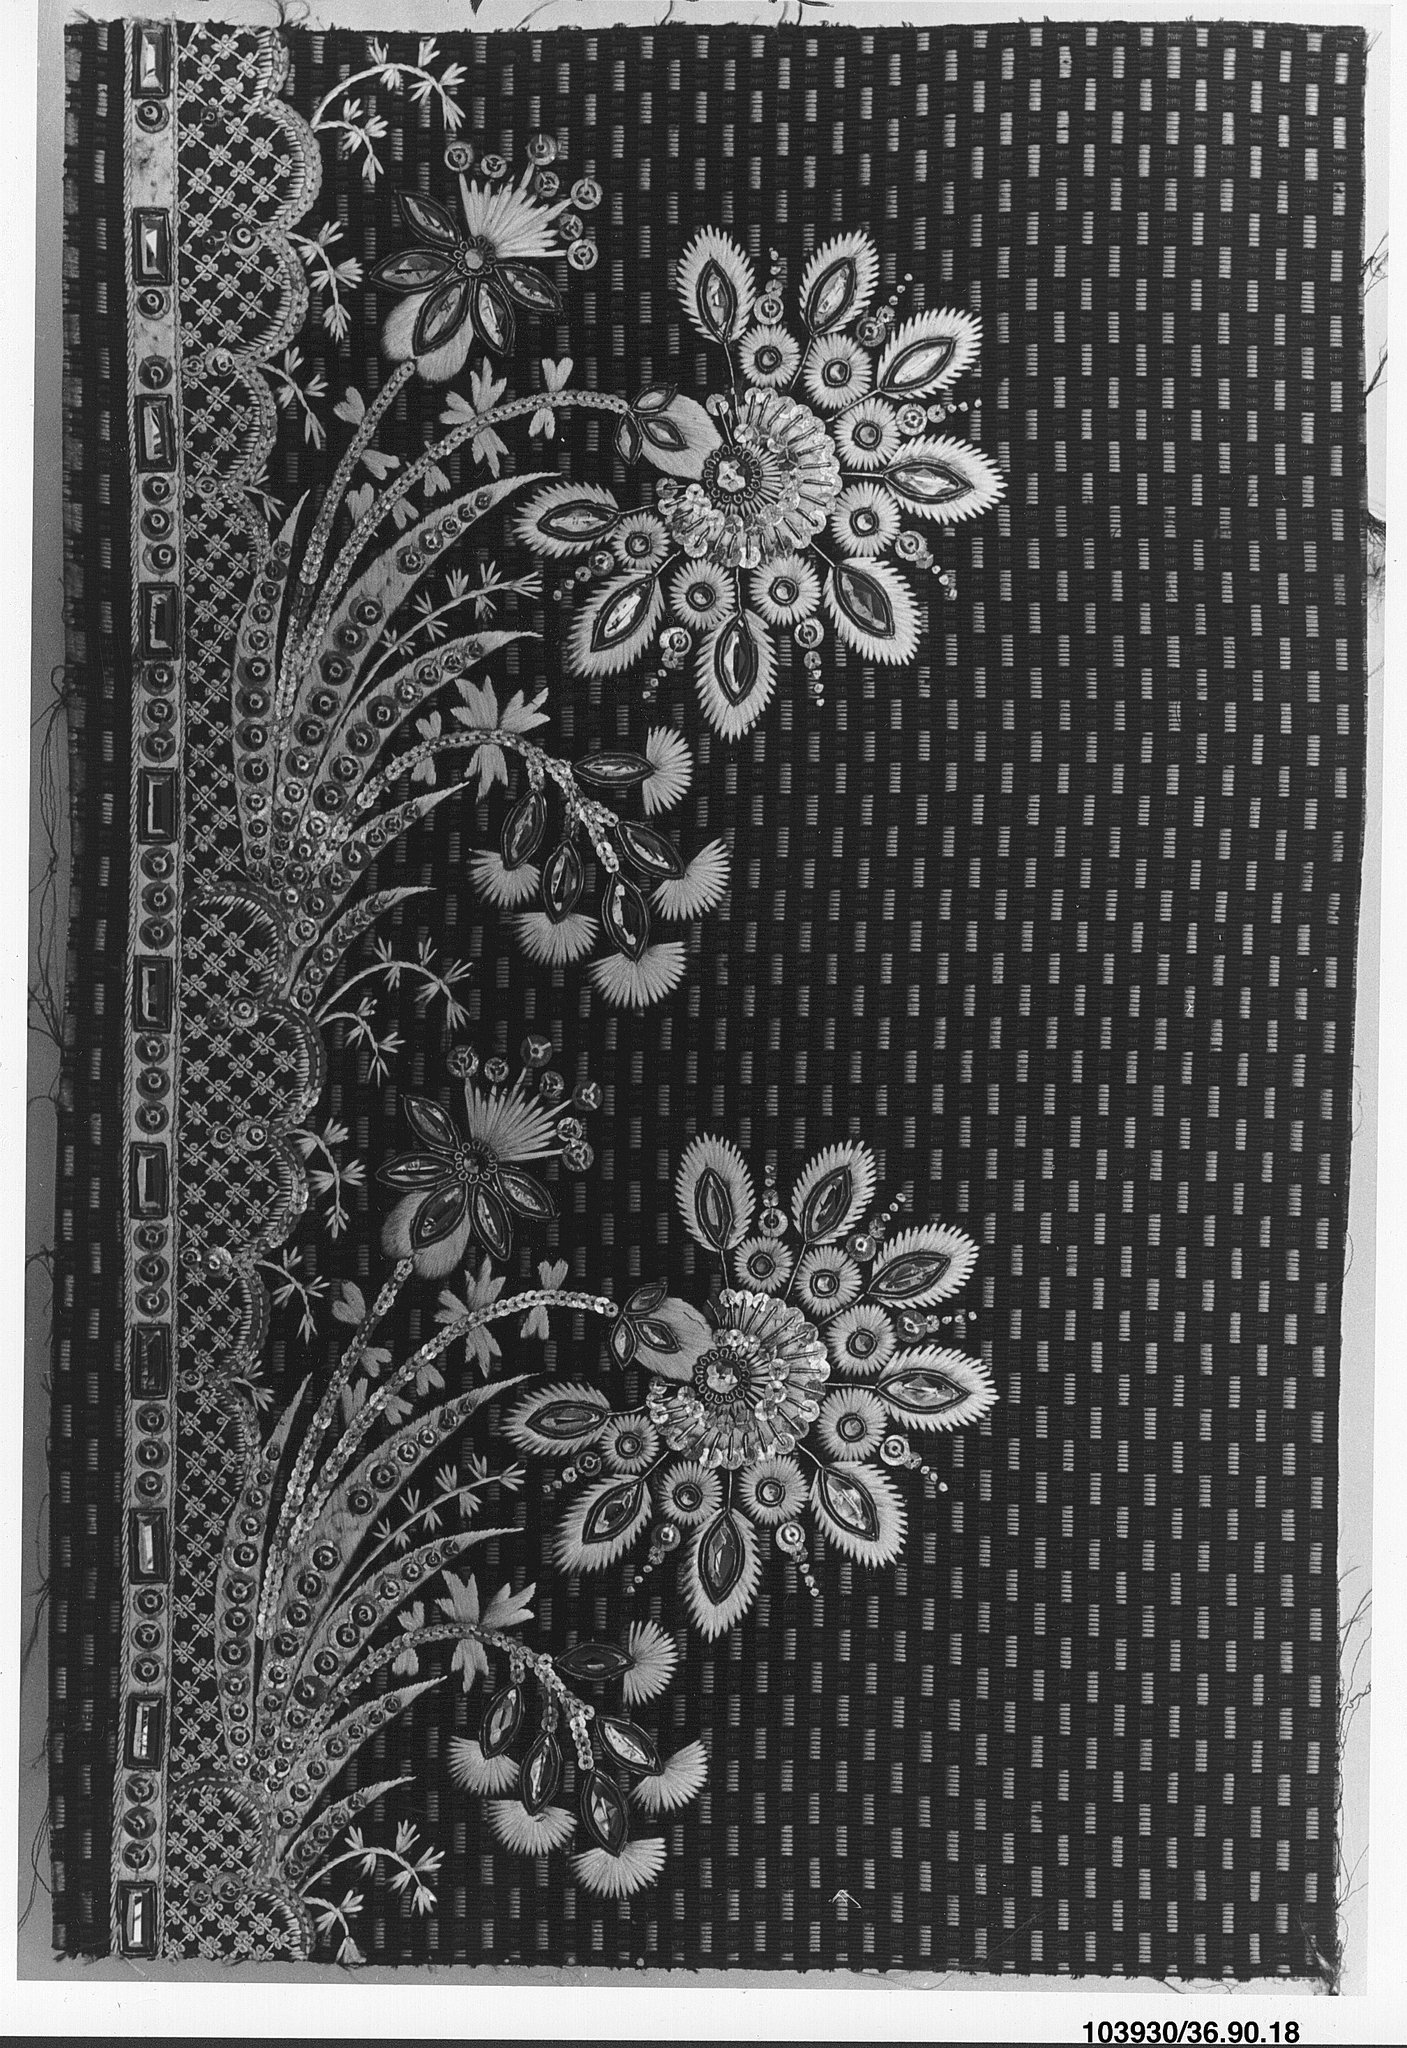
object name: sample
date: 1801-1833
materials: metal thread, silk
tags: flowers